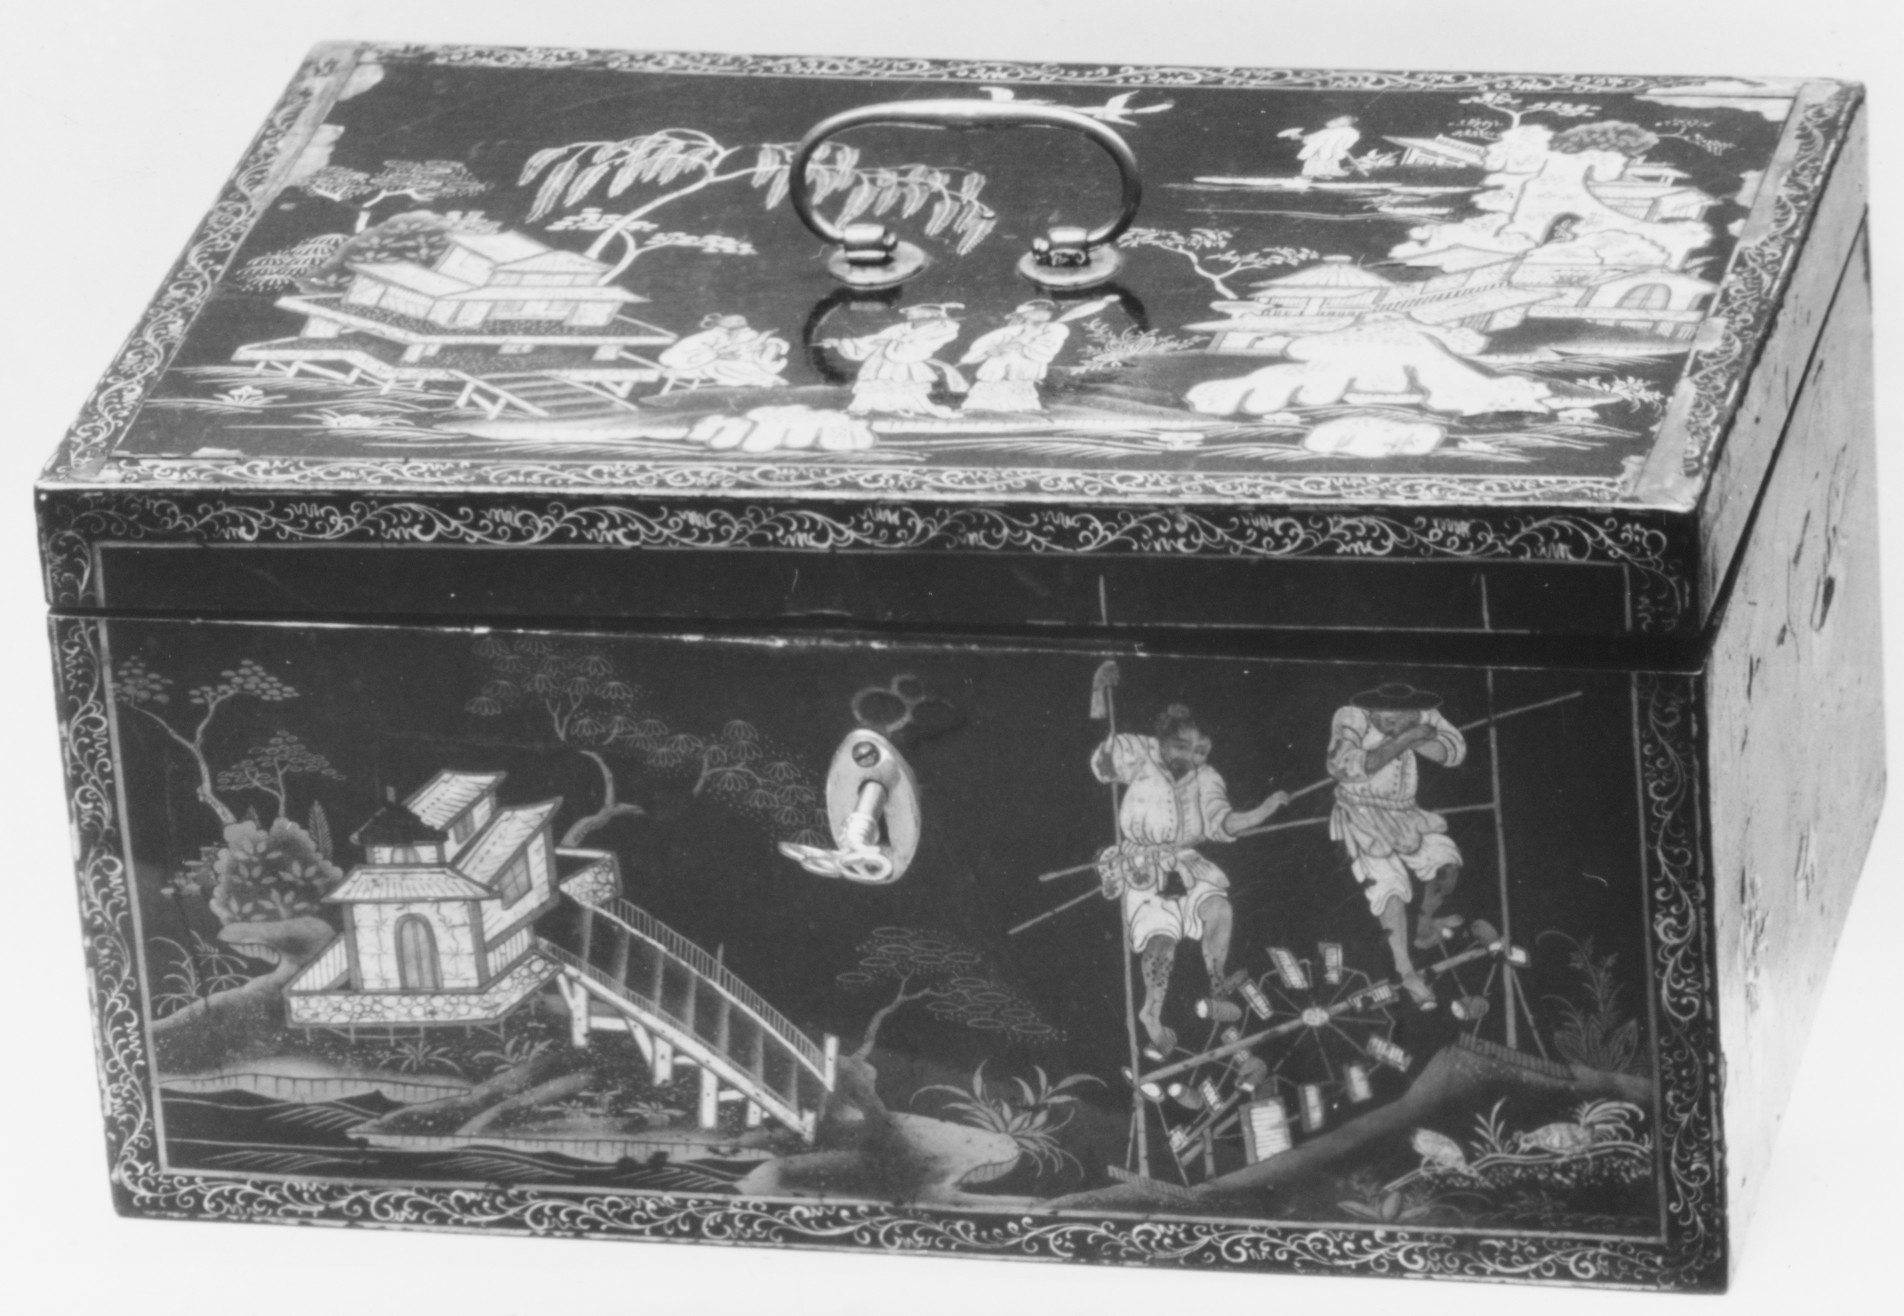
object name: box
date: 1801-1900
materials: brass, lacquer